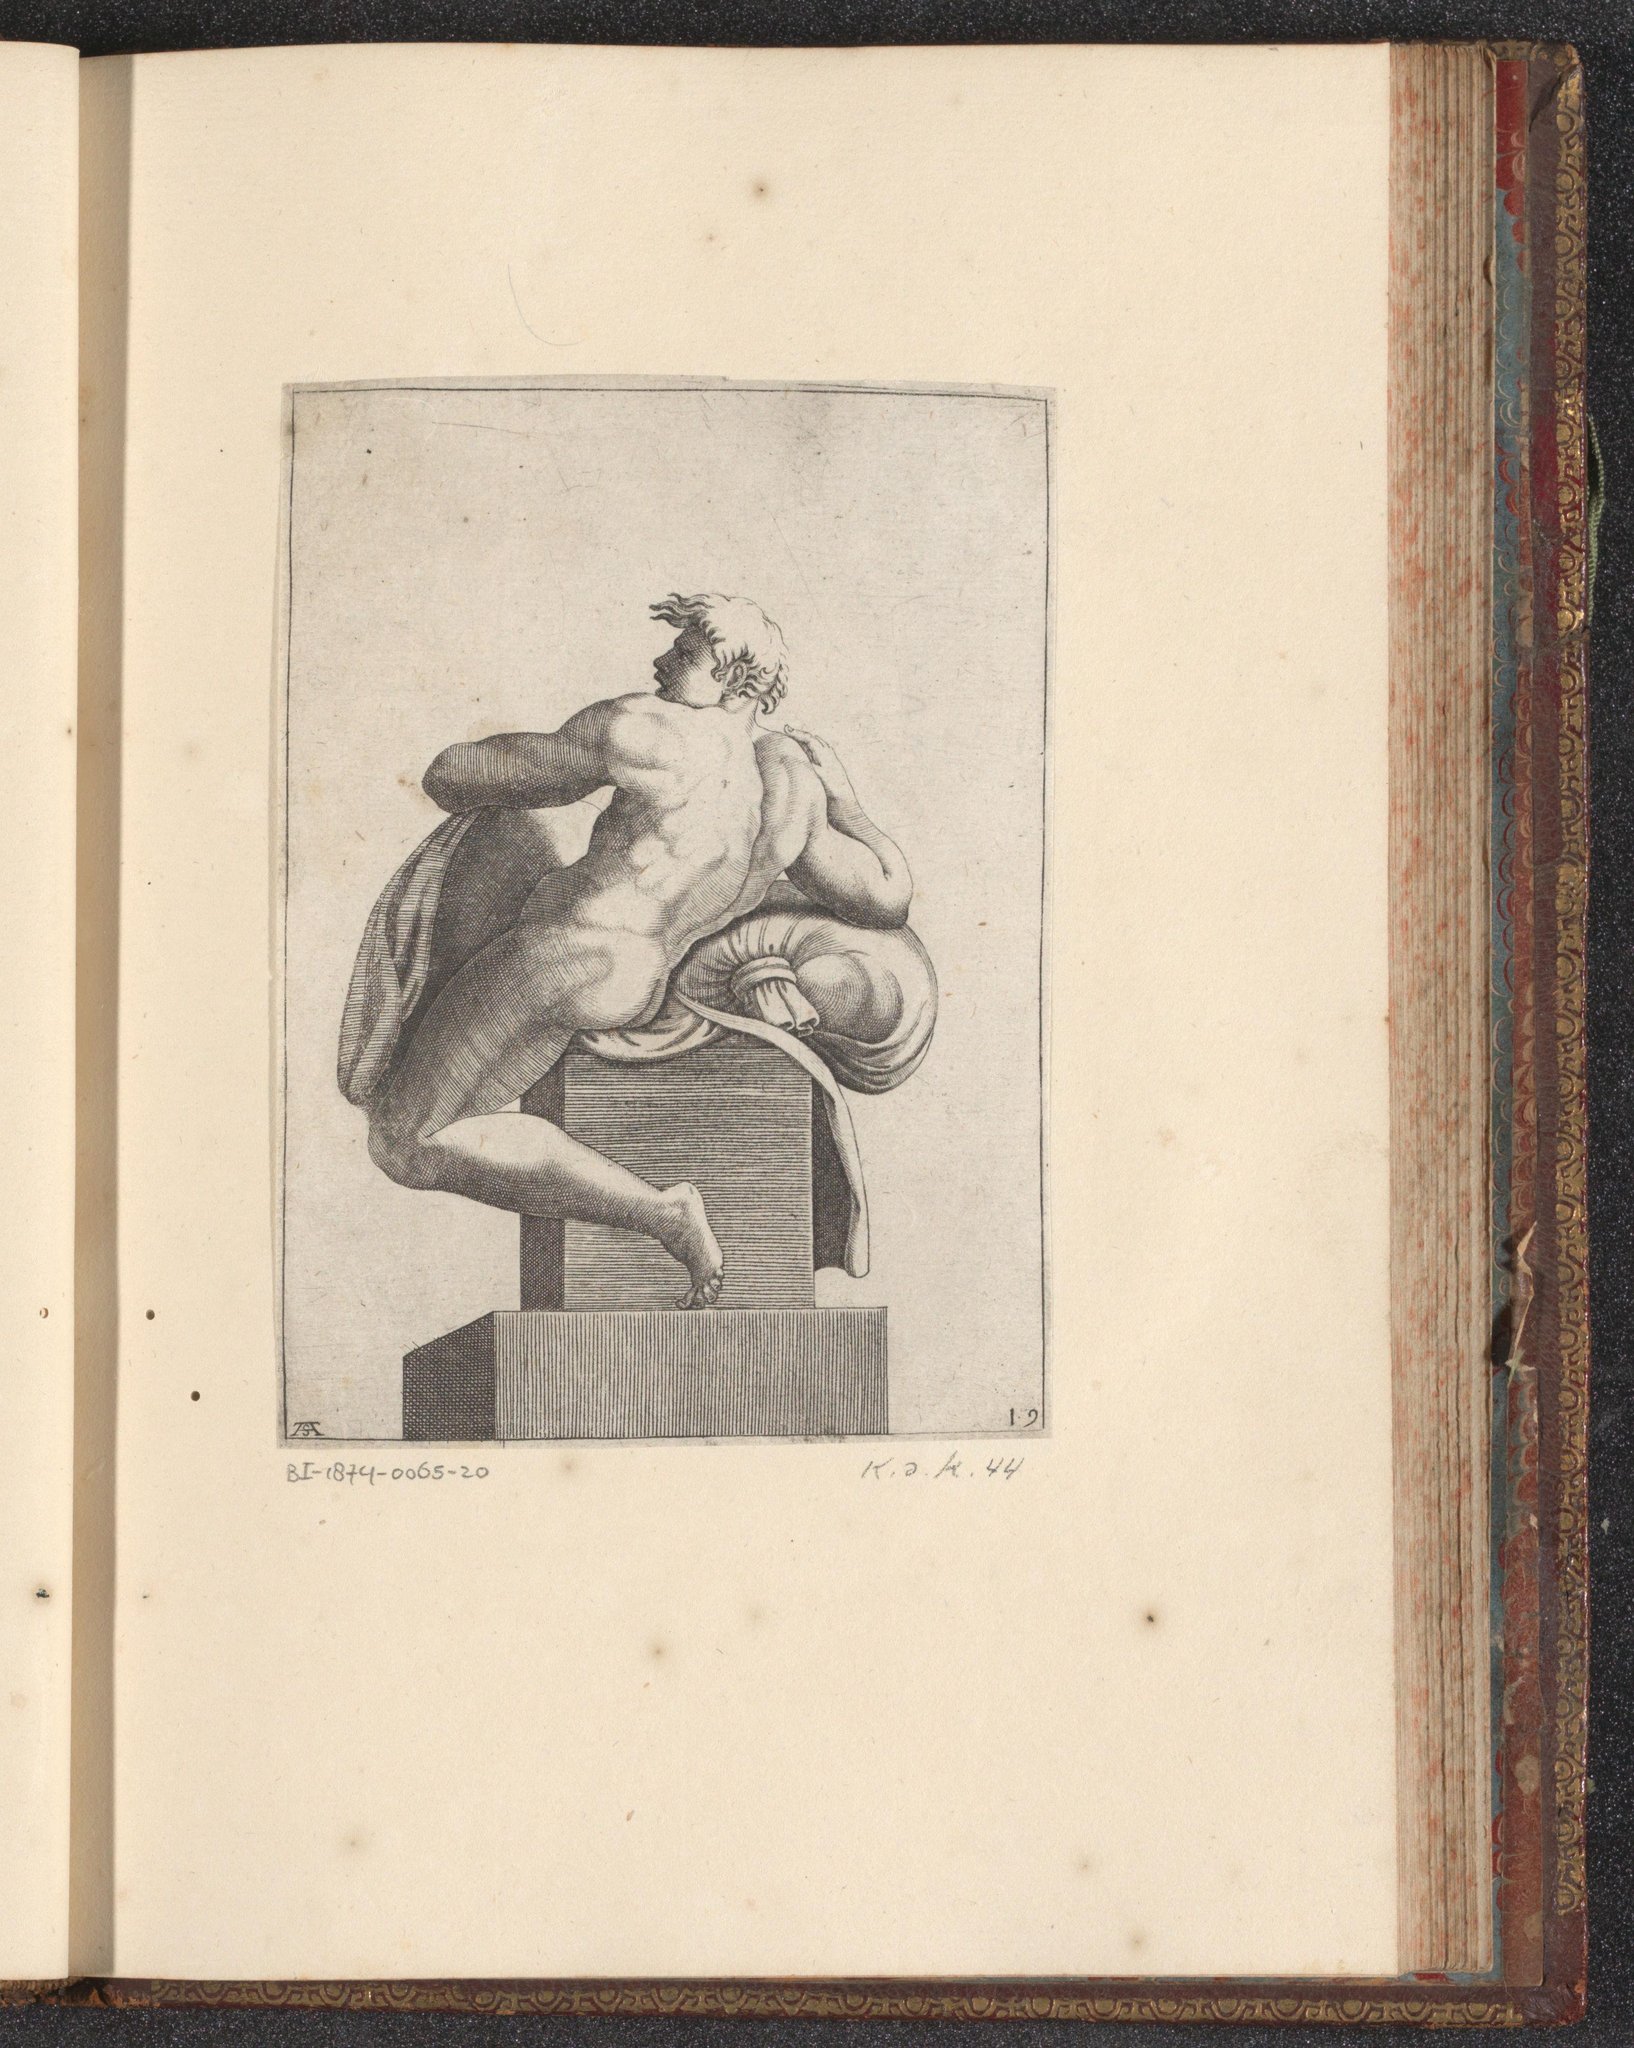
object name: print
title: Zittend naakt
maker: adamo scultori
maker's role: painter, print maker, sculptor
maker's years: 1530-1585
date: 1585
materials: paper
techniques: engraving, intaglio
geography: italy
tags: the (nude) human figure; 'corpo humano' (ripa)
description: Naakte man zittend op een kussen, naar links gedraaid. Eén van de 'ignudi' (naakte mannen) van Michelangelo's plafondschildering. Genummerd rechtsonder: 19. De prent maakt deel uit van een album.